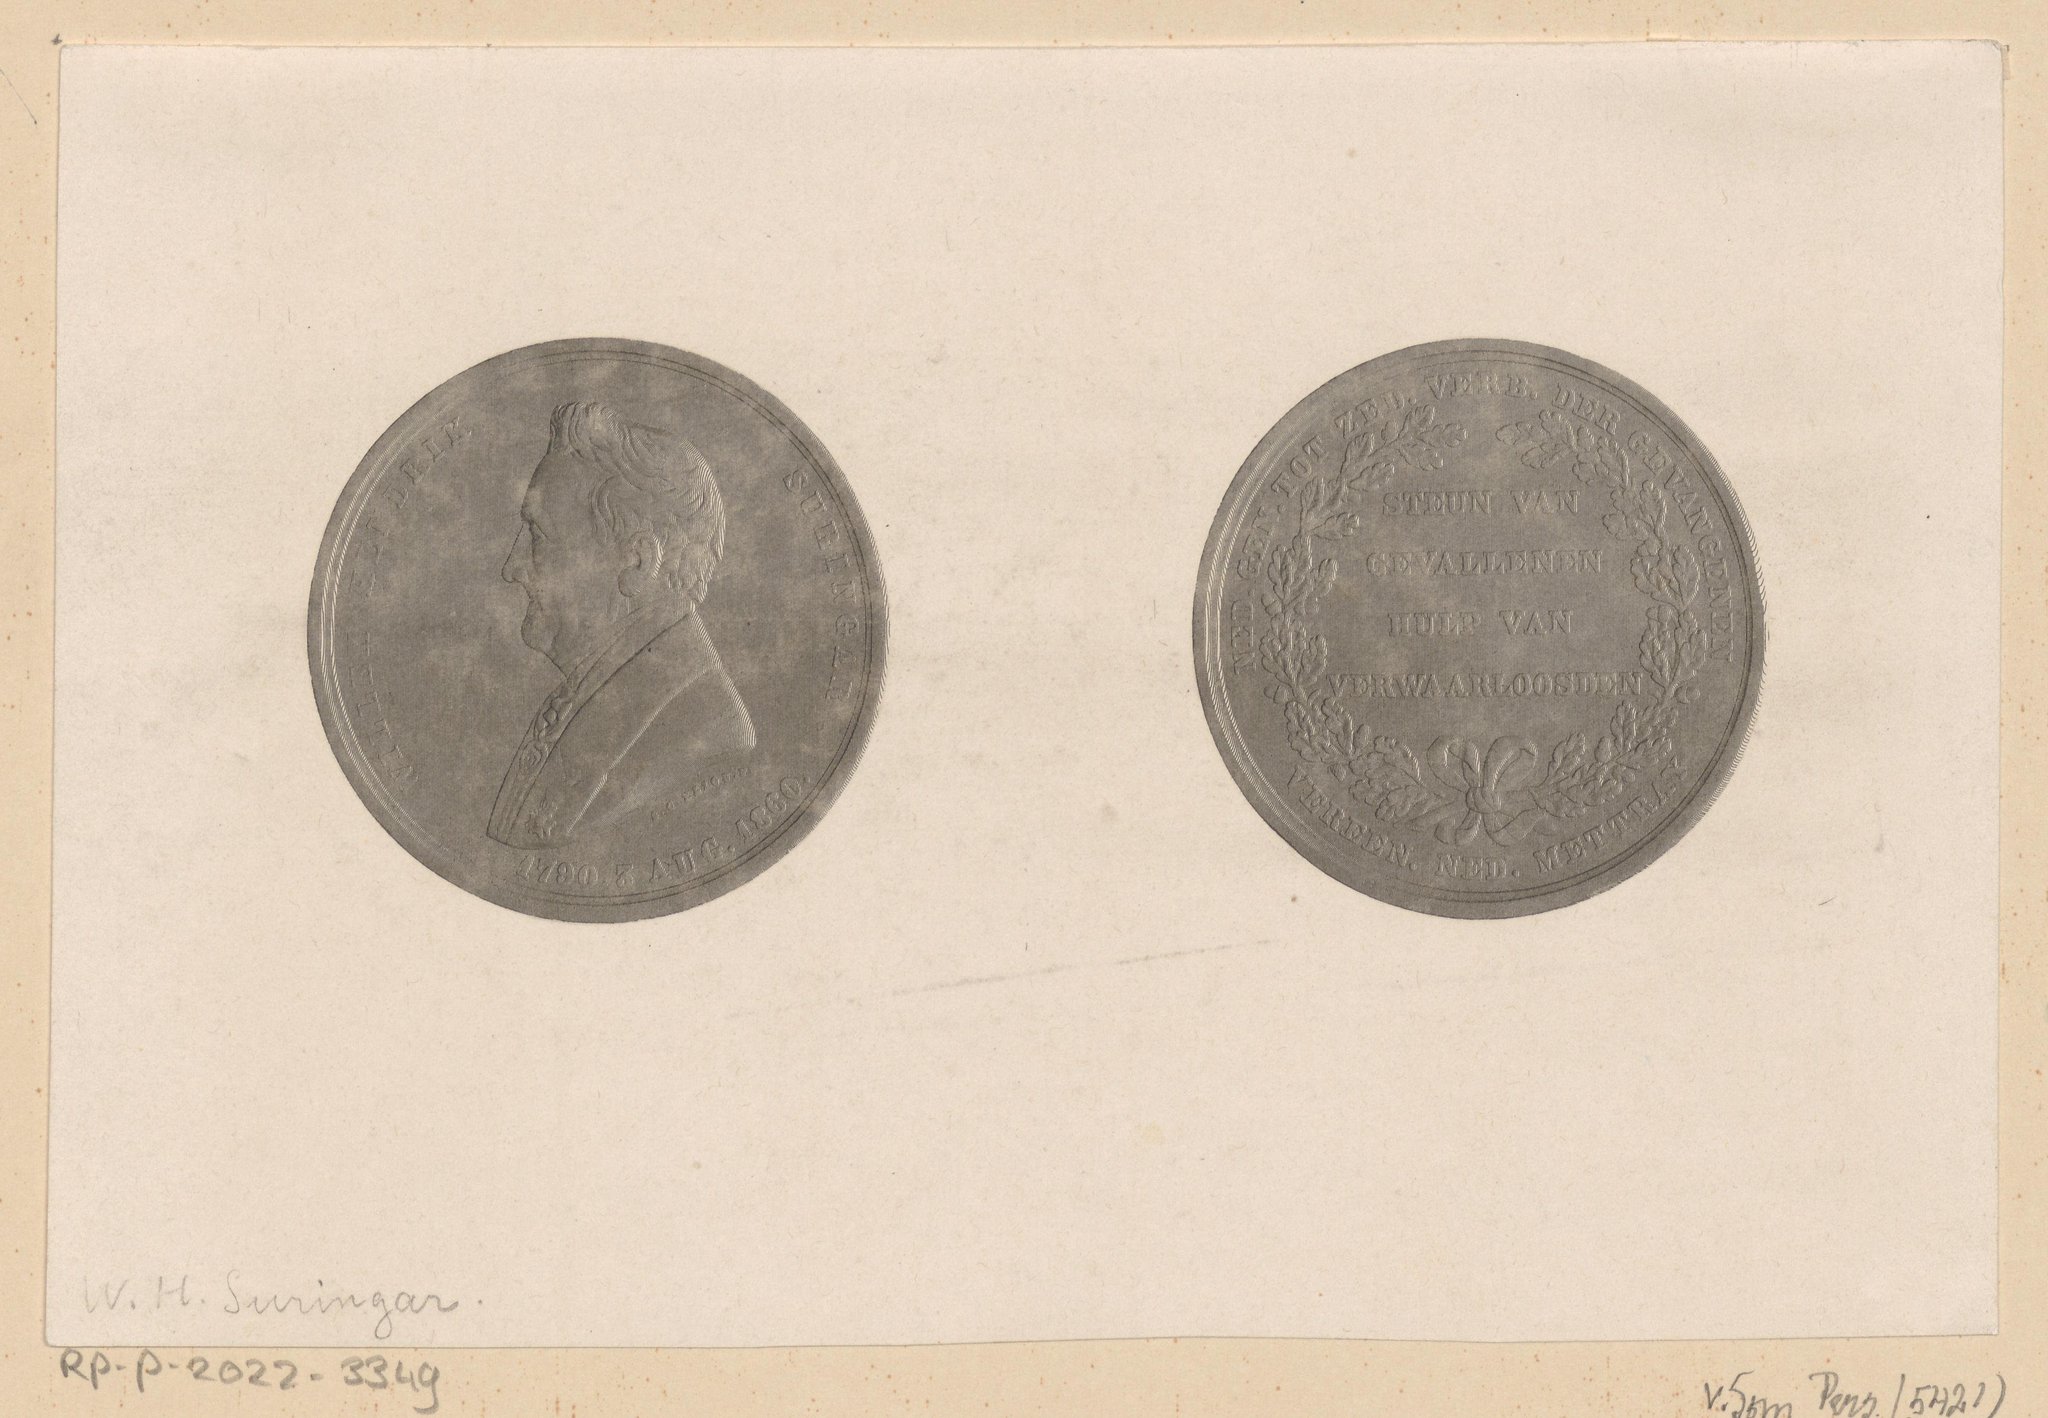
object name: print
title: Verjaardagspenning met een portret van Willem Hendrik Suringar op 70-jarige leeftijd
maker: Anonymous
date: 1860-1862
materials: paper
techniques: relief engraving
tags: amsterdam, philantropist, historical persons, coin